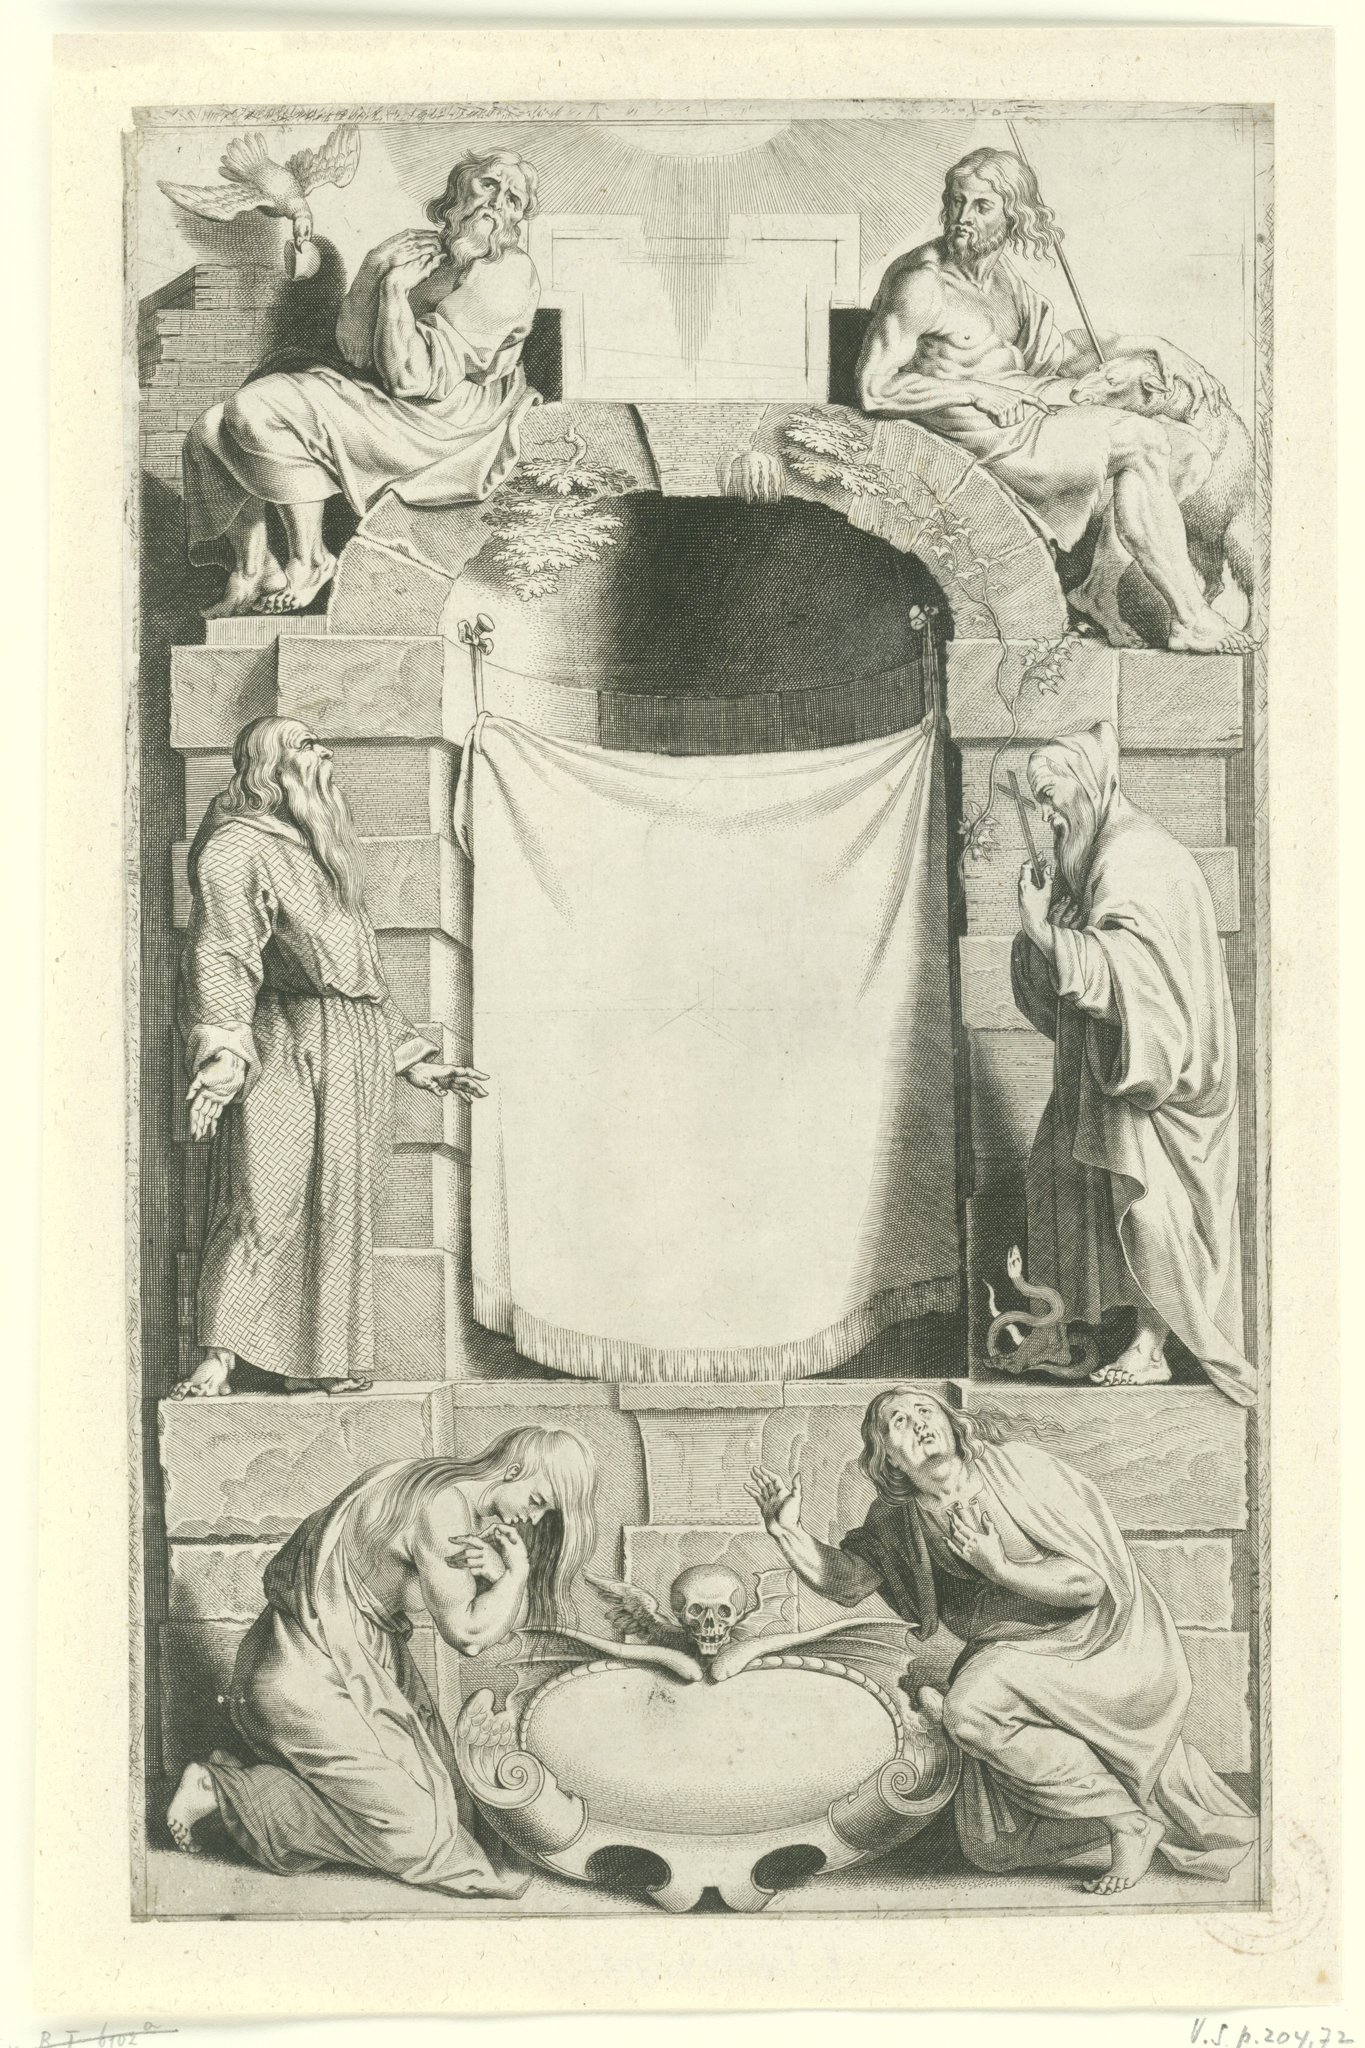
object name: titelblad, titelpagina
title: Titelpagina voor: H. Rosweyde, 'tVaders Boek, Antwerpen, 1617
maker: jan baptiste collaert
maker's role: print maker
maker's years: 1591-1627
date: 1617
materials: paper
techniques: engraving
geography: antwerp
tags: john the baptist; possible attributes: book, reed cross, baptismal cup, honeycomb, lamb, staff, elijah (not in biblical context); possible attributes: scroll and flaming sword, the penitent harlot mary magdalene; possible attributes: book (or scroll), crown, crown of thorns, crucifix, jar of ointment, mirror, musical instrument, palm-branch, rosary, scourge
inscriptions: collector's mark: Lugt 240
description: Een nis waarvoor een witte doek. Aan weerszijden van de nis de heilige Paulus en Antonius in monnikspij. Boven op de nis links Elia (met een raaf die hem brood brengt), rechts Johannes de Doper met zijn lam. Midden onder de heilige Eugenia en Paula, zittend bij een cartouche met gevleugeld doodshoofd.